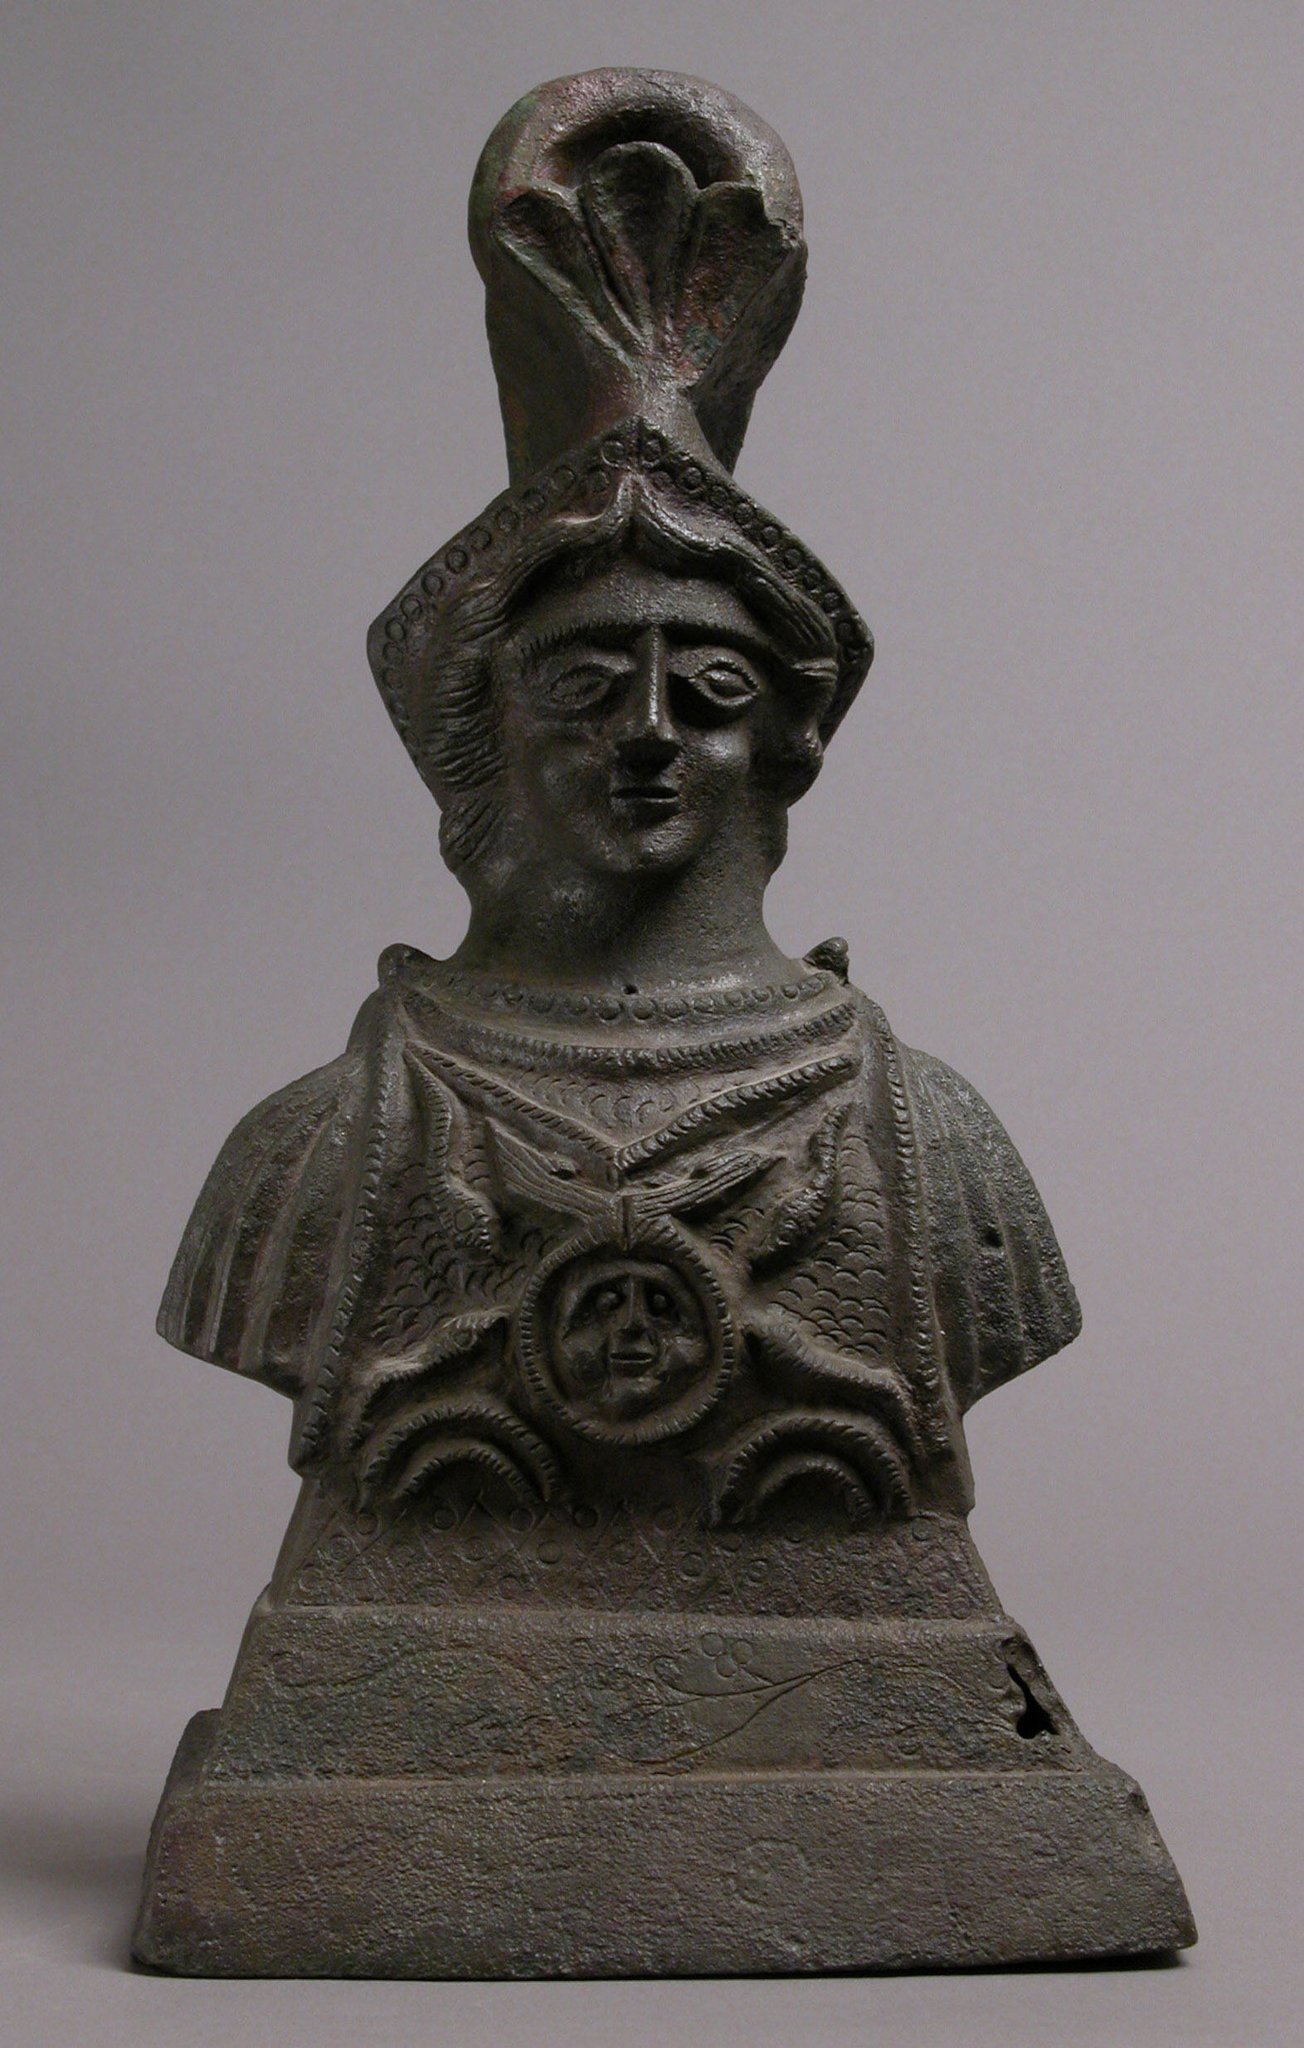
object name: steelyard weight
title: Weight, Steelyard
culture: byzantine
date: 301-333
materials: copper alloy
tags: human figures